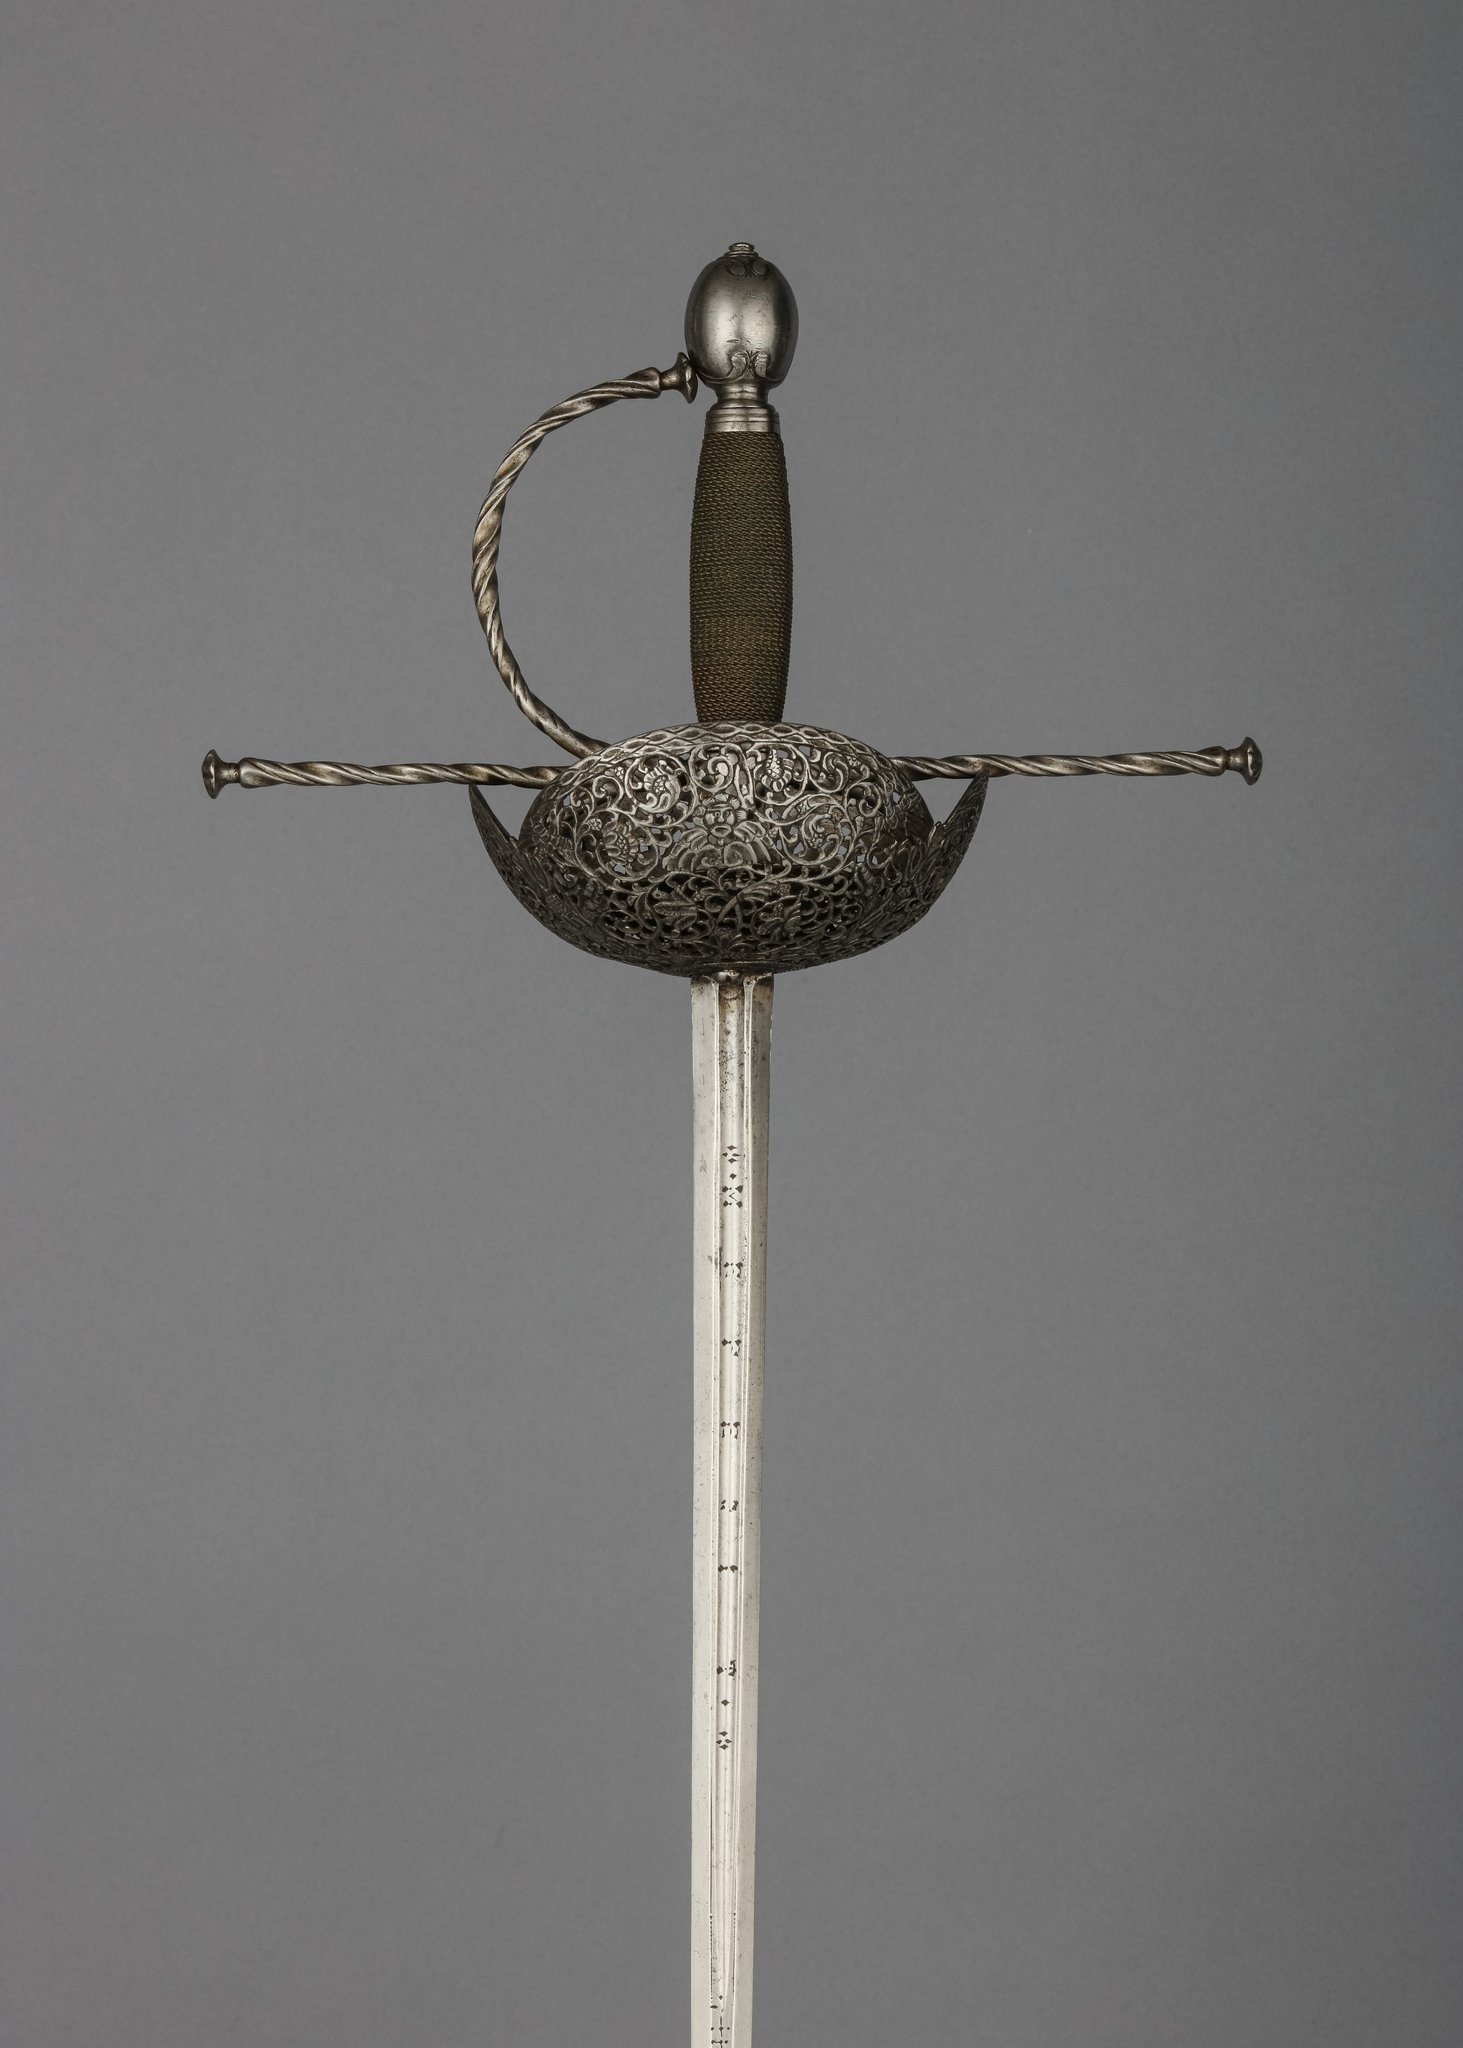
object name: cup hilted rapier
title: Cup-Hilted Rapier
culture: spanish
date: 1650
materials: steel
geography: spain